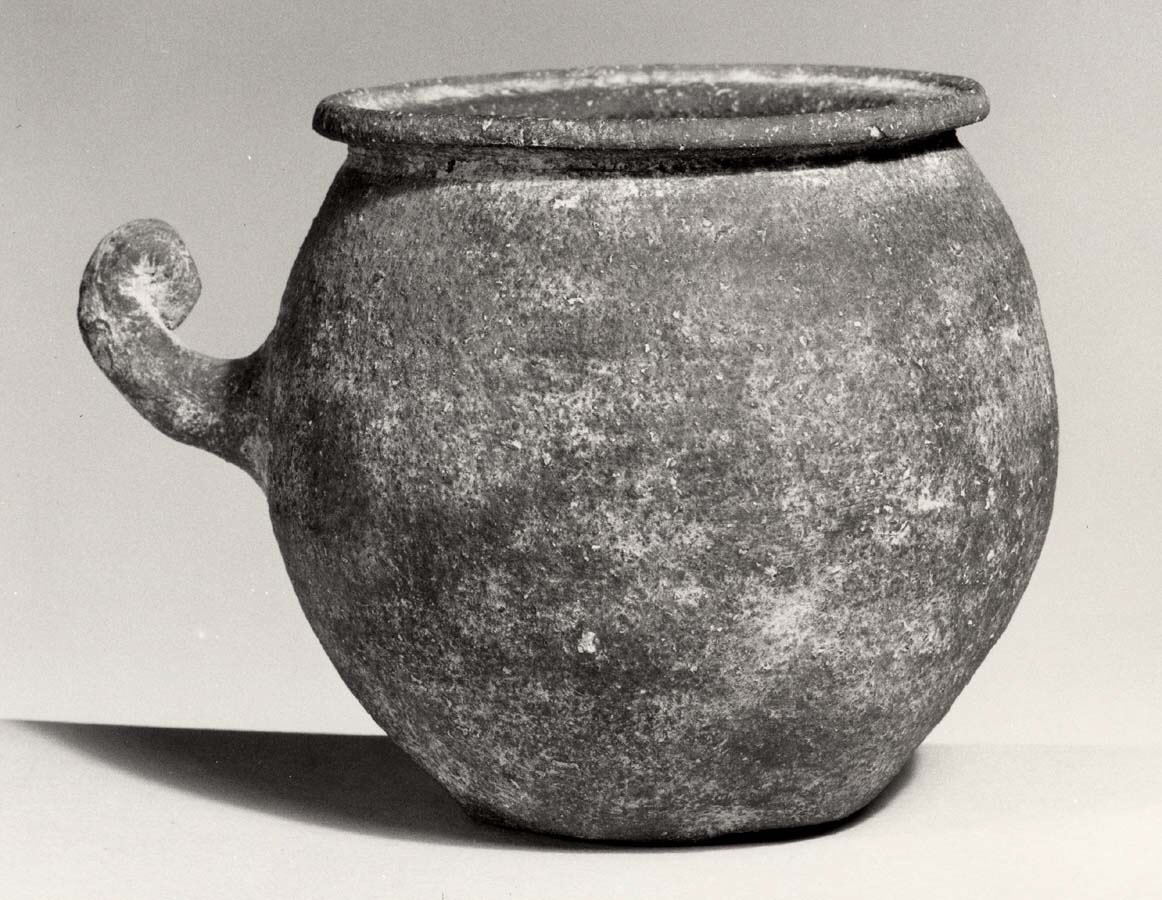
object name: cup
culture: korean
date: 301-600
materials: earthenware